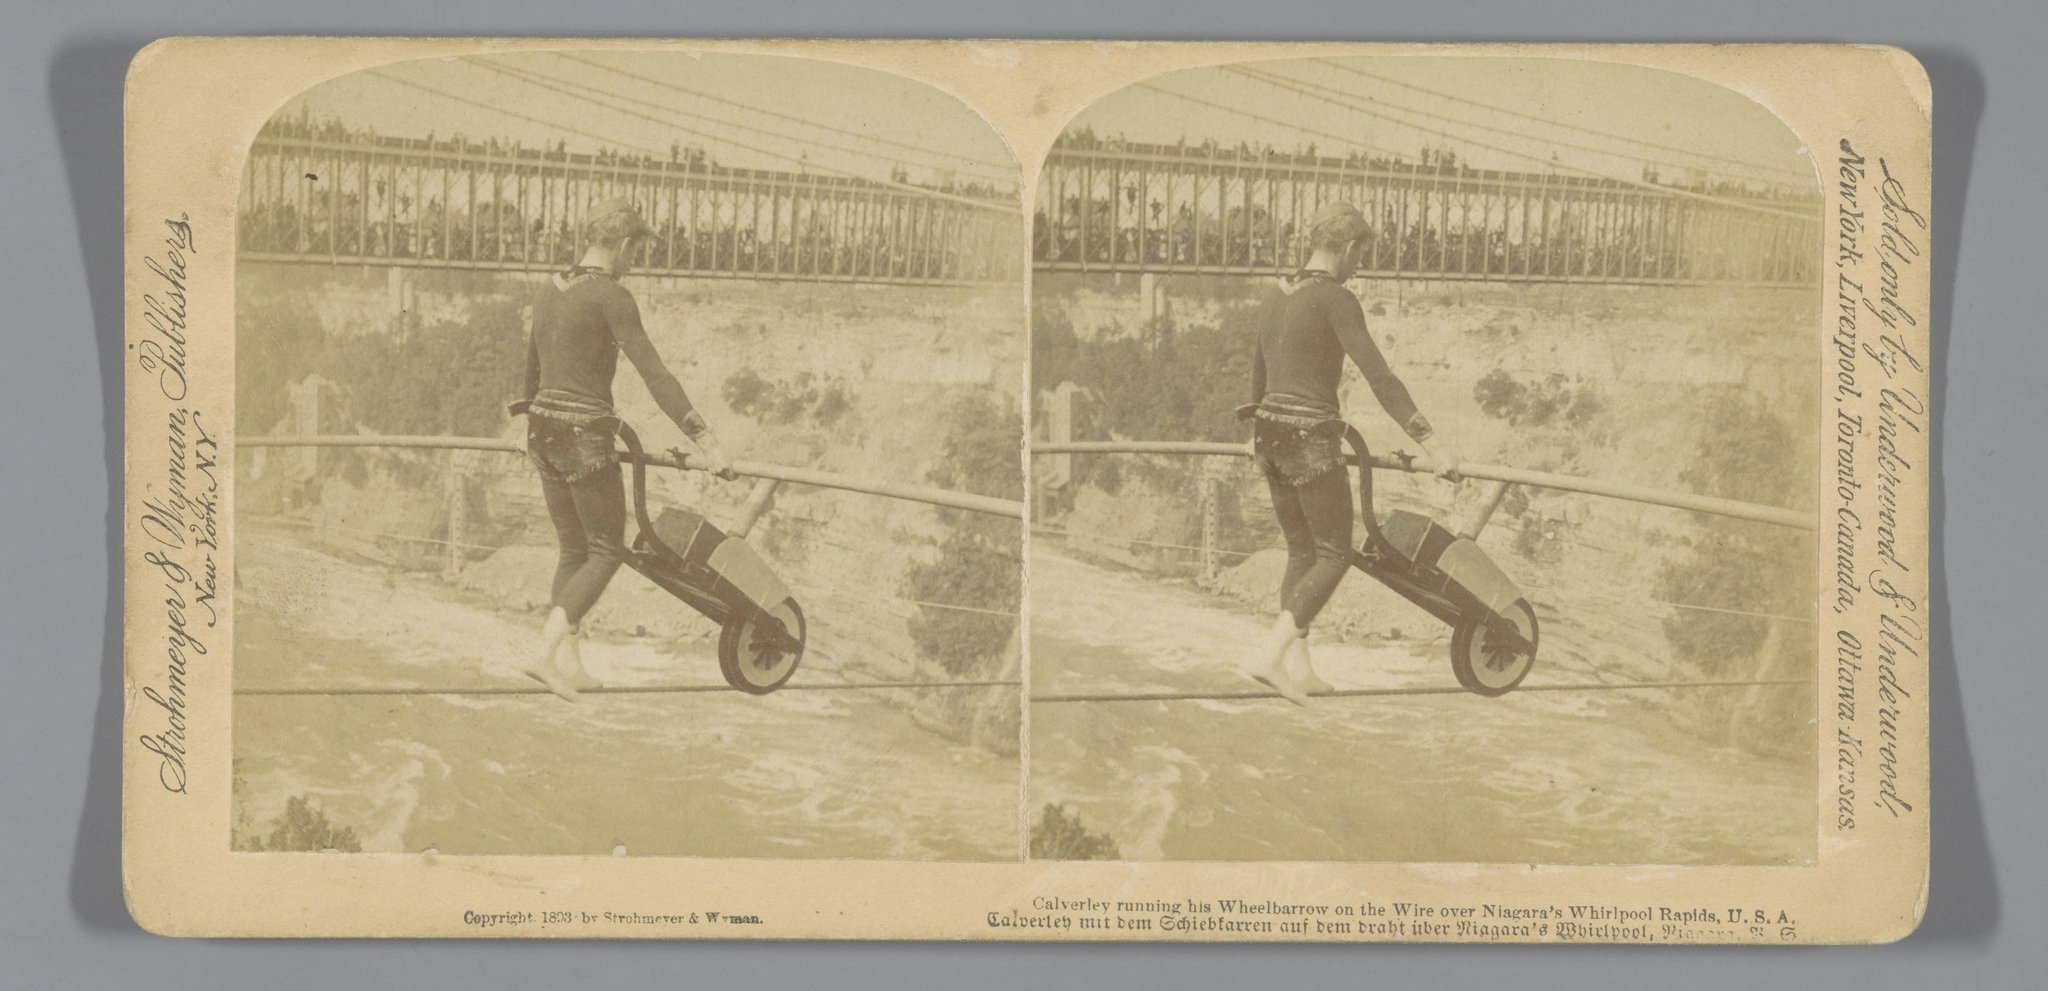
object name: stereograph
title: Acrobaat Clifford M. Calverley balancerend op een touw boven de Niagarawatervallen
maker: Anonymous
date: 1893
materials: cardboard, paper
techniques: albumen print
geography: new york city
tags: equilibrist, waterfall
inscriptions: title: ‘Calverley, the World's Champion, crossing the Cable over Rapids Niagara, U. S. A.’, copyright notice: ‘Copyright 1893 by Strohmeyer & Wymann.’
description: Calverly deed al eerder twee geslaagde pogingen de maalstroom bij de Niagarawatervallen over te steken. Op 12 oktober 1892 vestigde hij het record om in minder dan 6 minuten de tocht te maken. Deze foto is van zijn derde poging in juli 1893.